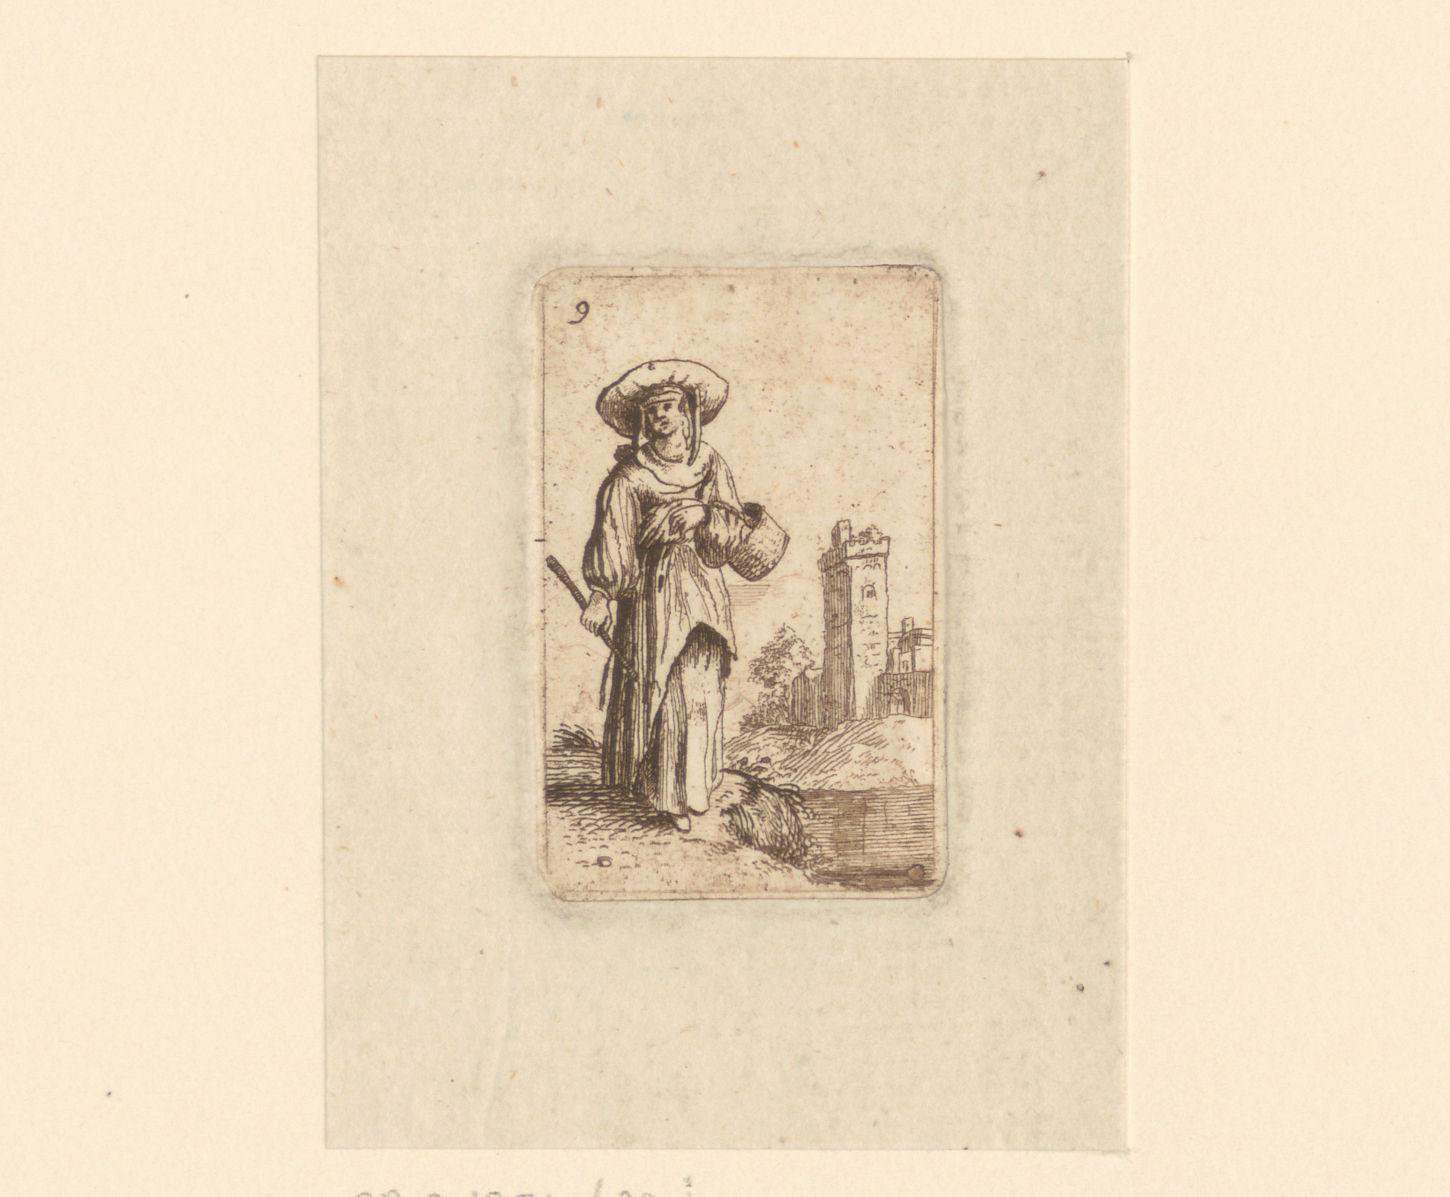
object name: print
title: Figure Subjects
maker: paul sandby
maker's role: draughtsman, print maker, publisher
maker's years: 1725-1809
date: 1735-1809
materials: paper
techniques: etching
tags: adult woman, container made of plant material other than wood: basket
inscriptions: collector's mark: Lugt 2228